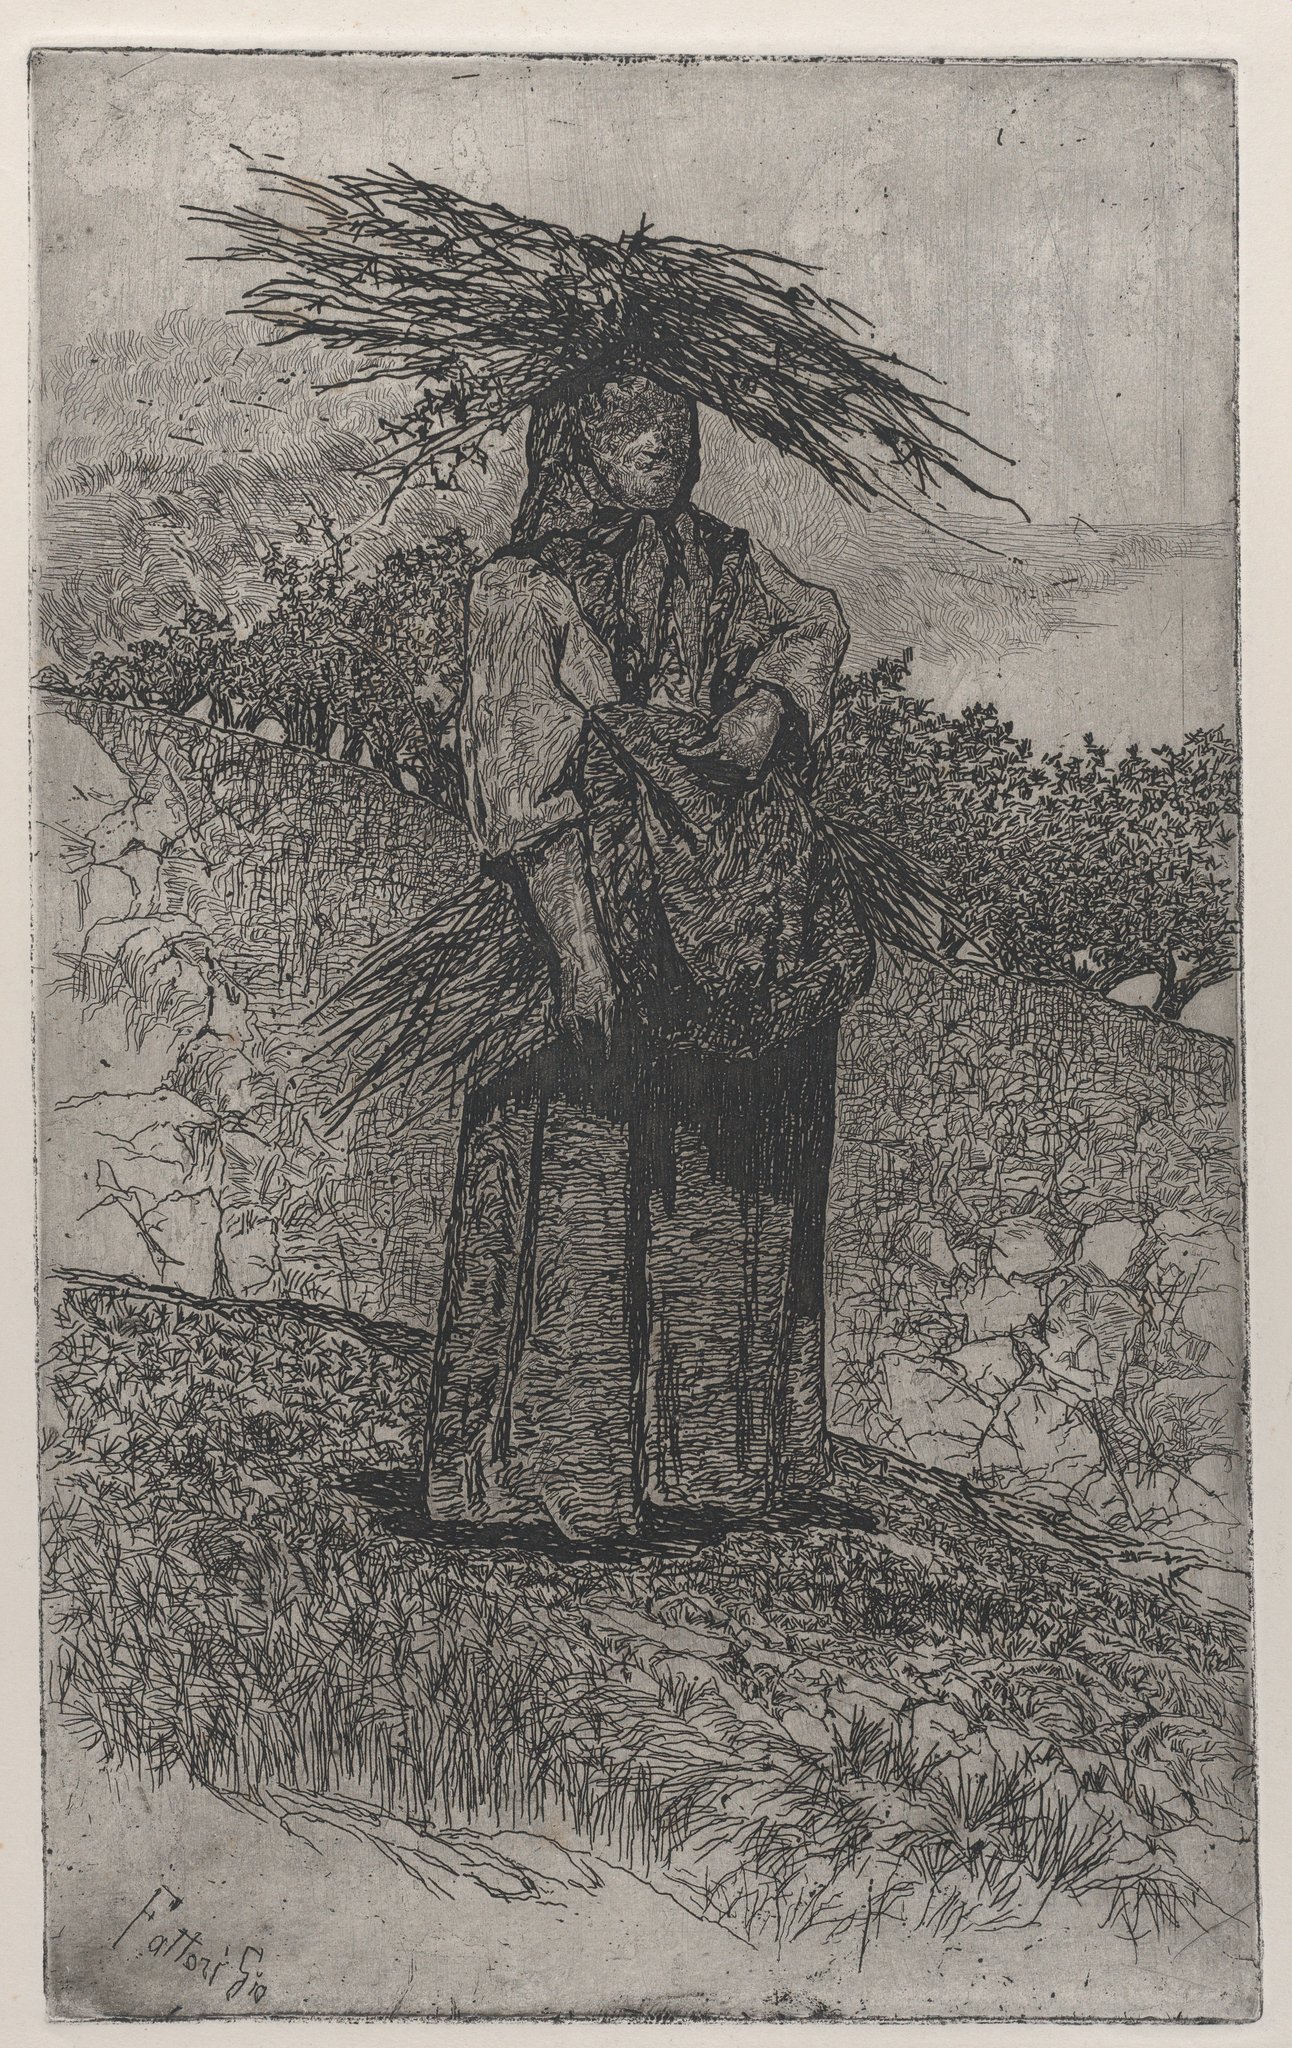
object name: print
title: Peasant woman gathering sticks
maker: giovanni fattori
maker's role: artist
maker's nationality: italian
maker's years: 1825-1908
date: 1884-1908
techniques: etching